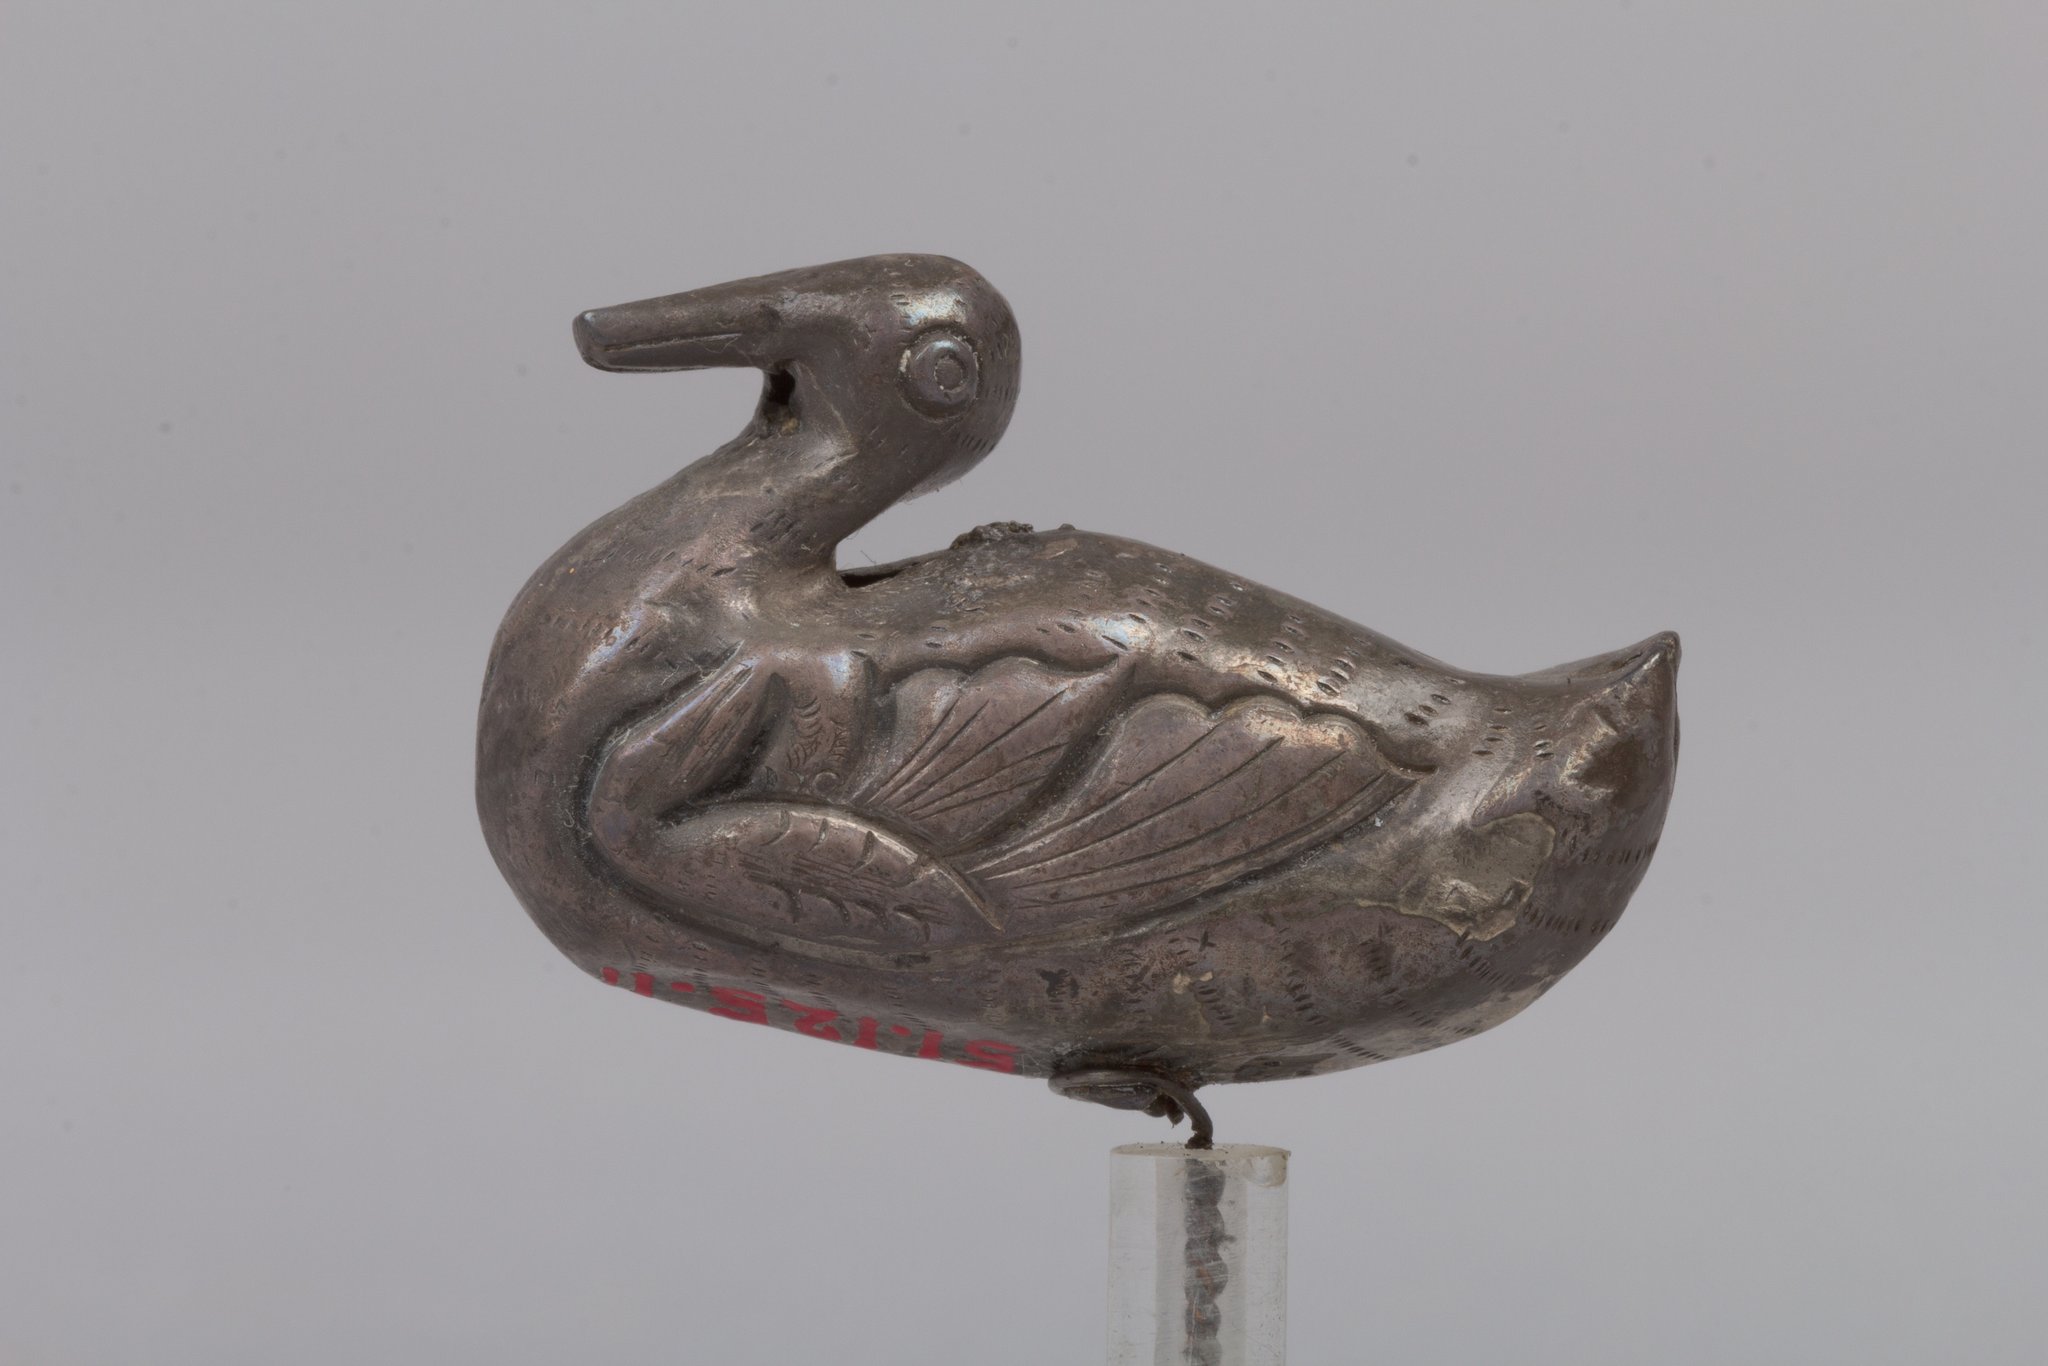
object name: figure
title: Duck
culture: chinese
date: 618-907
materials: silver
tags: ducks